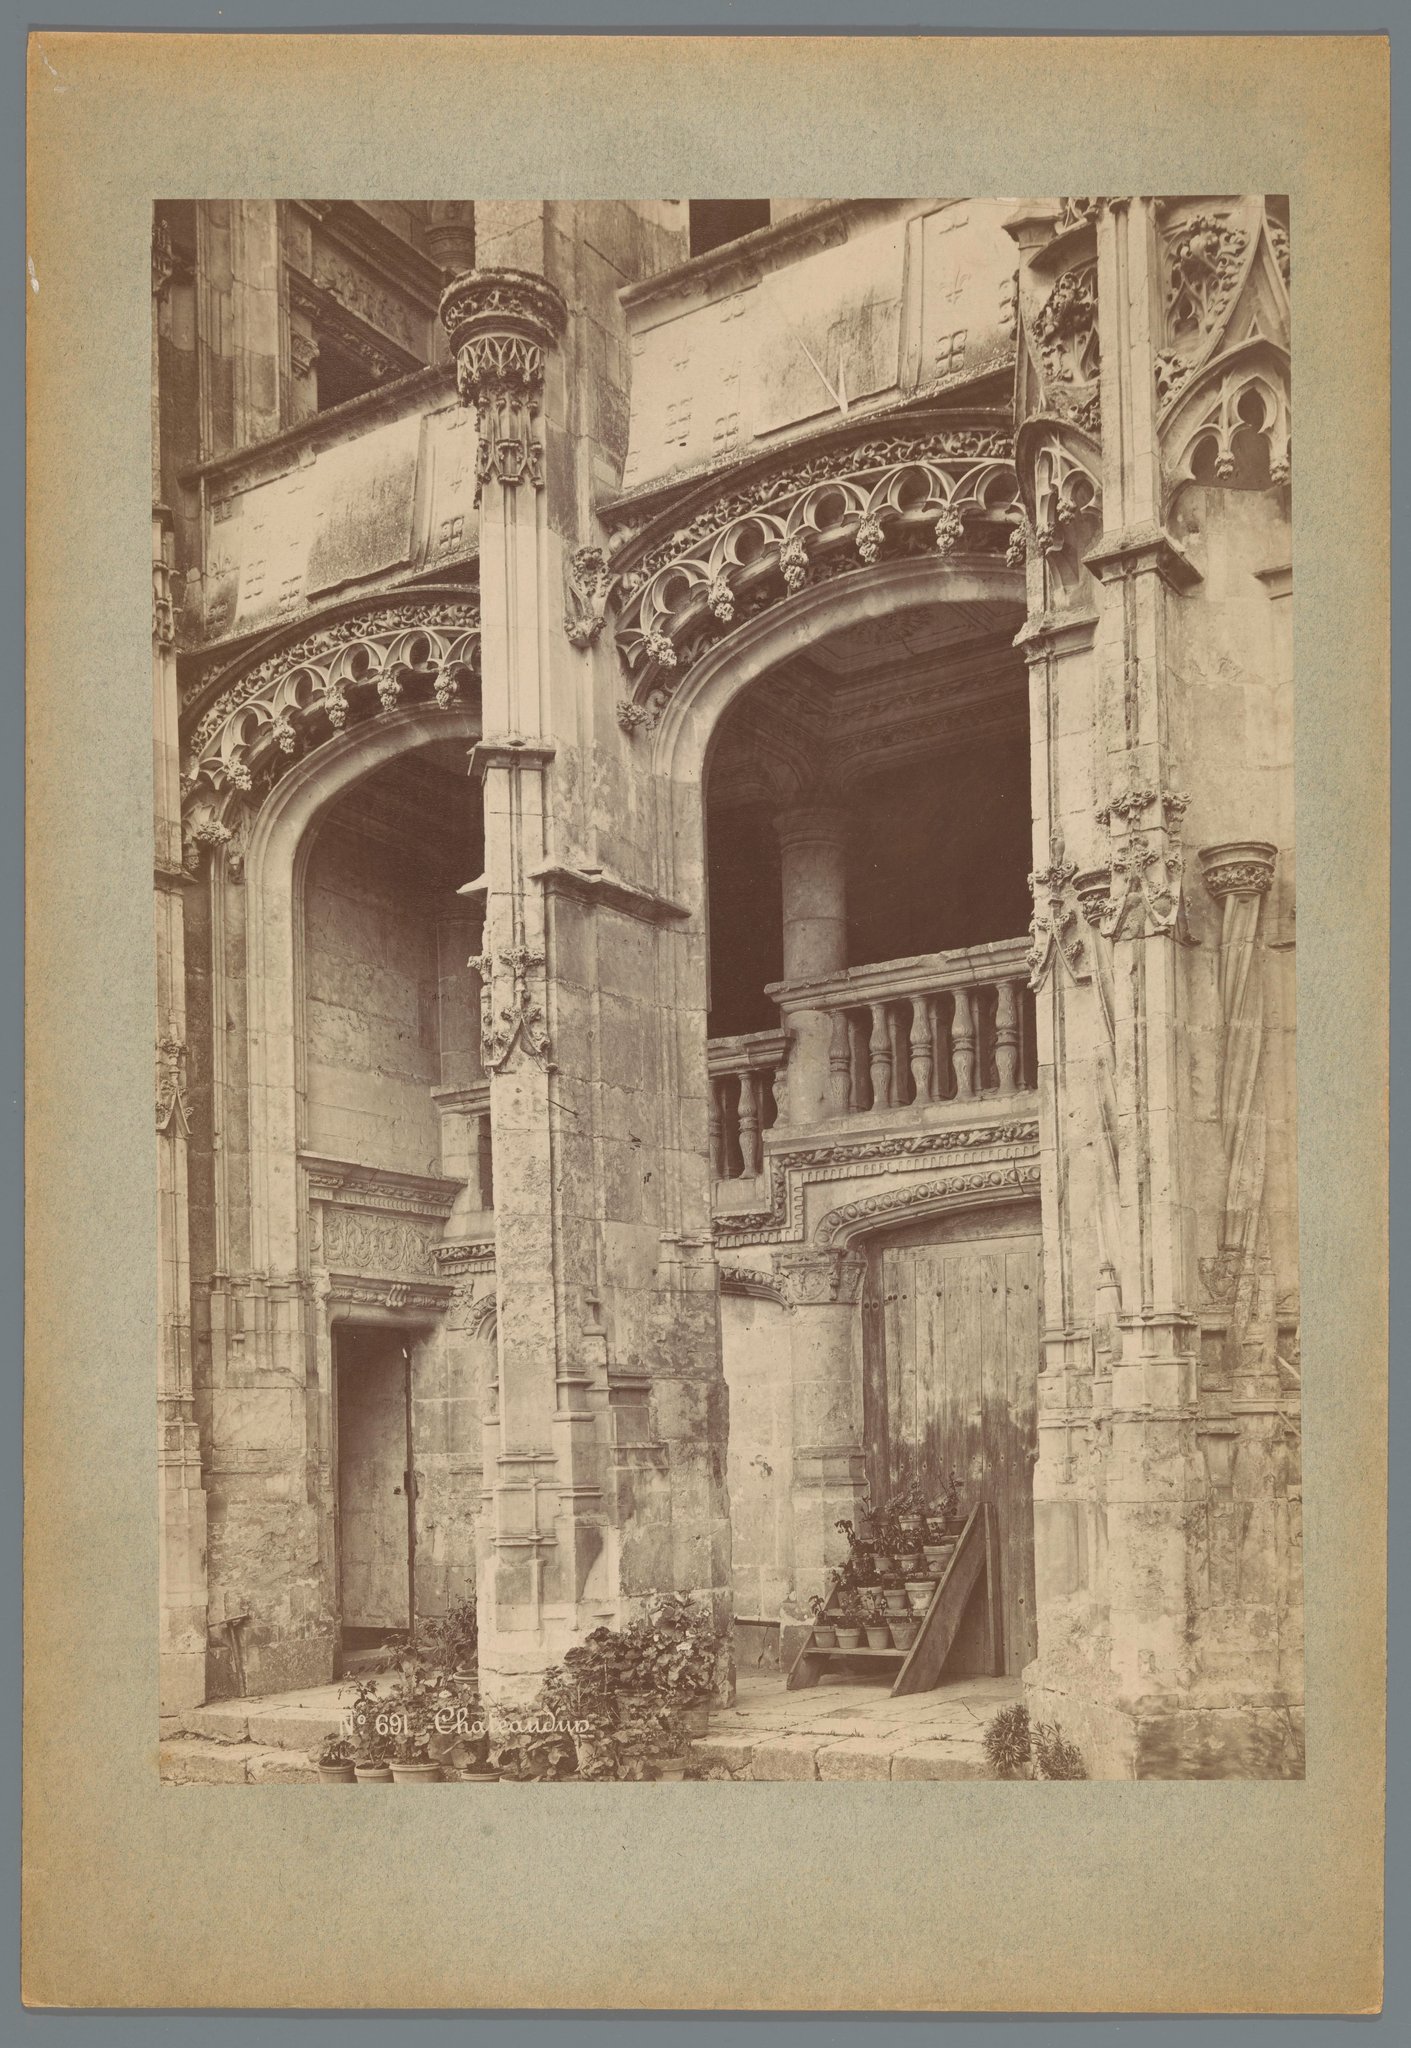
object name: photograph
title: Trappenhuis van Château Châteaudun met bloempotten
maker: séraphin-médéric mieusement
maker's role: fotograaf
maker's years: 1840-1905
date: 1875-1900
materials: cardboard, photographic support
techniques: albumen print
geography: châteaudun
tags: castle, shrubs: box, staircase, façade (of house or building)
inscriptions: name: ‘MIEUSEMENT PHOTOGRAPHE’, name: ‘MONUMENTS HISTORIQUES’, collector's mark: Lugt 3937, number: ‘No. 691’, name: ‘KUNSTBOEKHANDEL J. A. G. DE LEUR PHOTOGRAAF - UITGEVER Huigenspark, 40b. DEN HAAG’, inscription: ‘X k 1 pl 1’